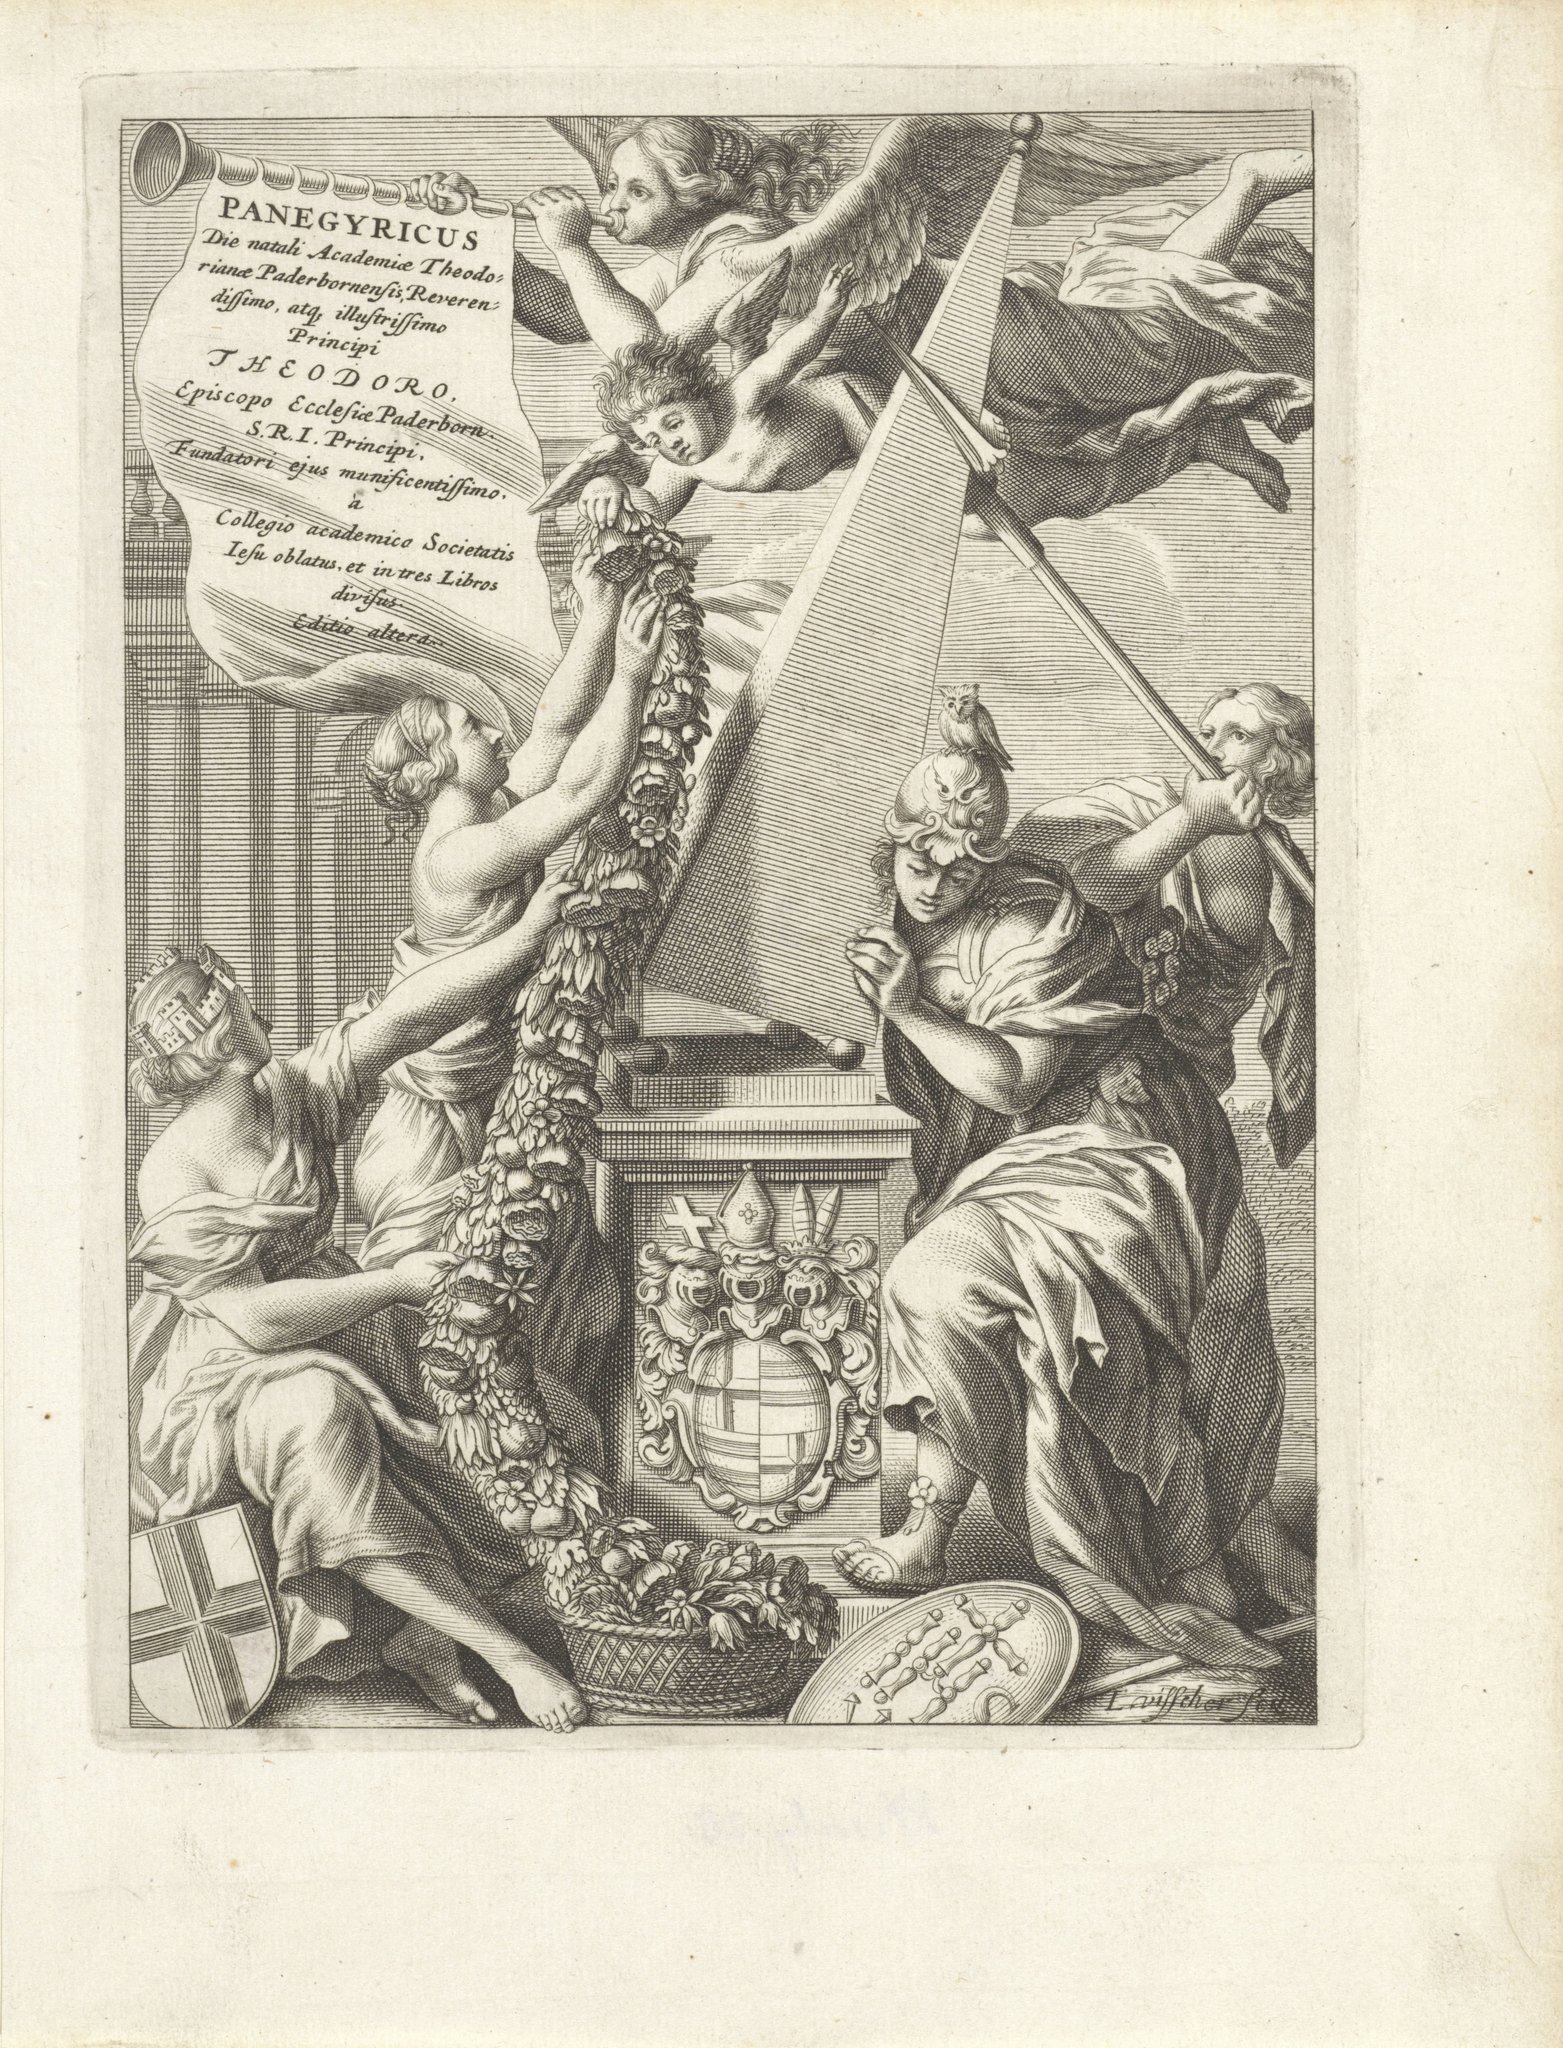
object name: print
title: Minerva richt een obelisk op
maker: lambert visscher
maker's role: draughtsman, print maker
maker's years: 1640-1679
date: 1672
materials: paper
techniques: engraving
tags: flowers, obelisk, needle, (story of) minerva (pallas, athena), fame; 'fama', 'fama buona', 'fama chiara' (ripa)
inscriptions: collector's mark: Lugt 2760, collector's mark: Lugt 2228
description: Minerva richt een obelisk op terwijl de Stedenmaagd van Paderborn helpt om een guilande te plaatsen. Fama blaast op haar loftrompet.